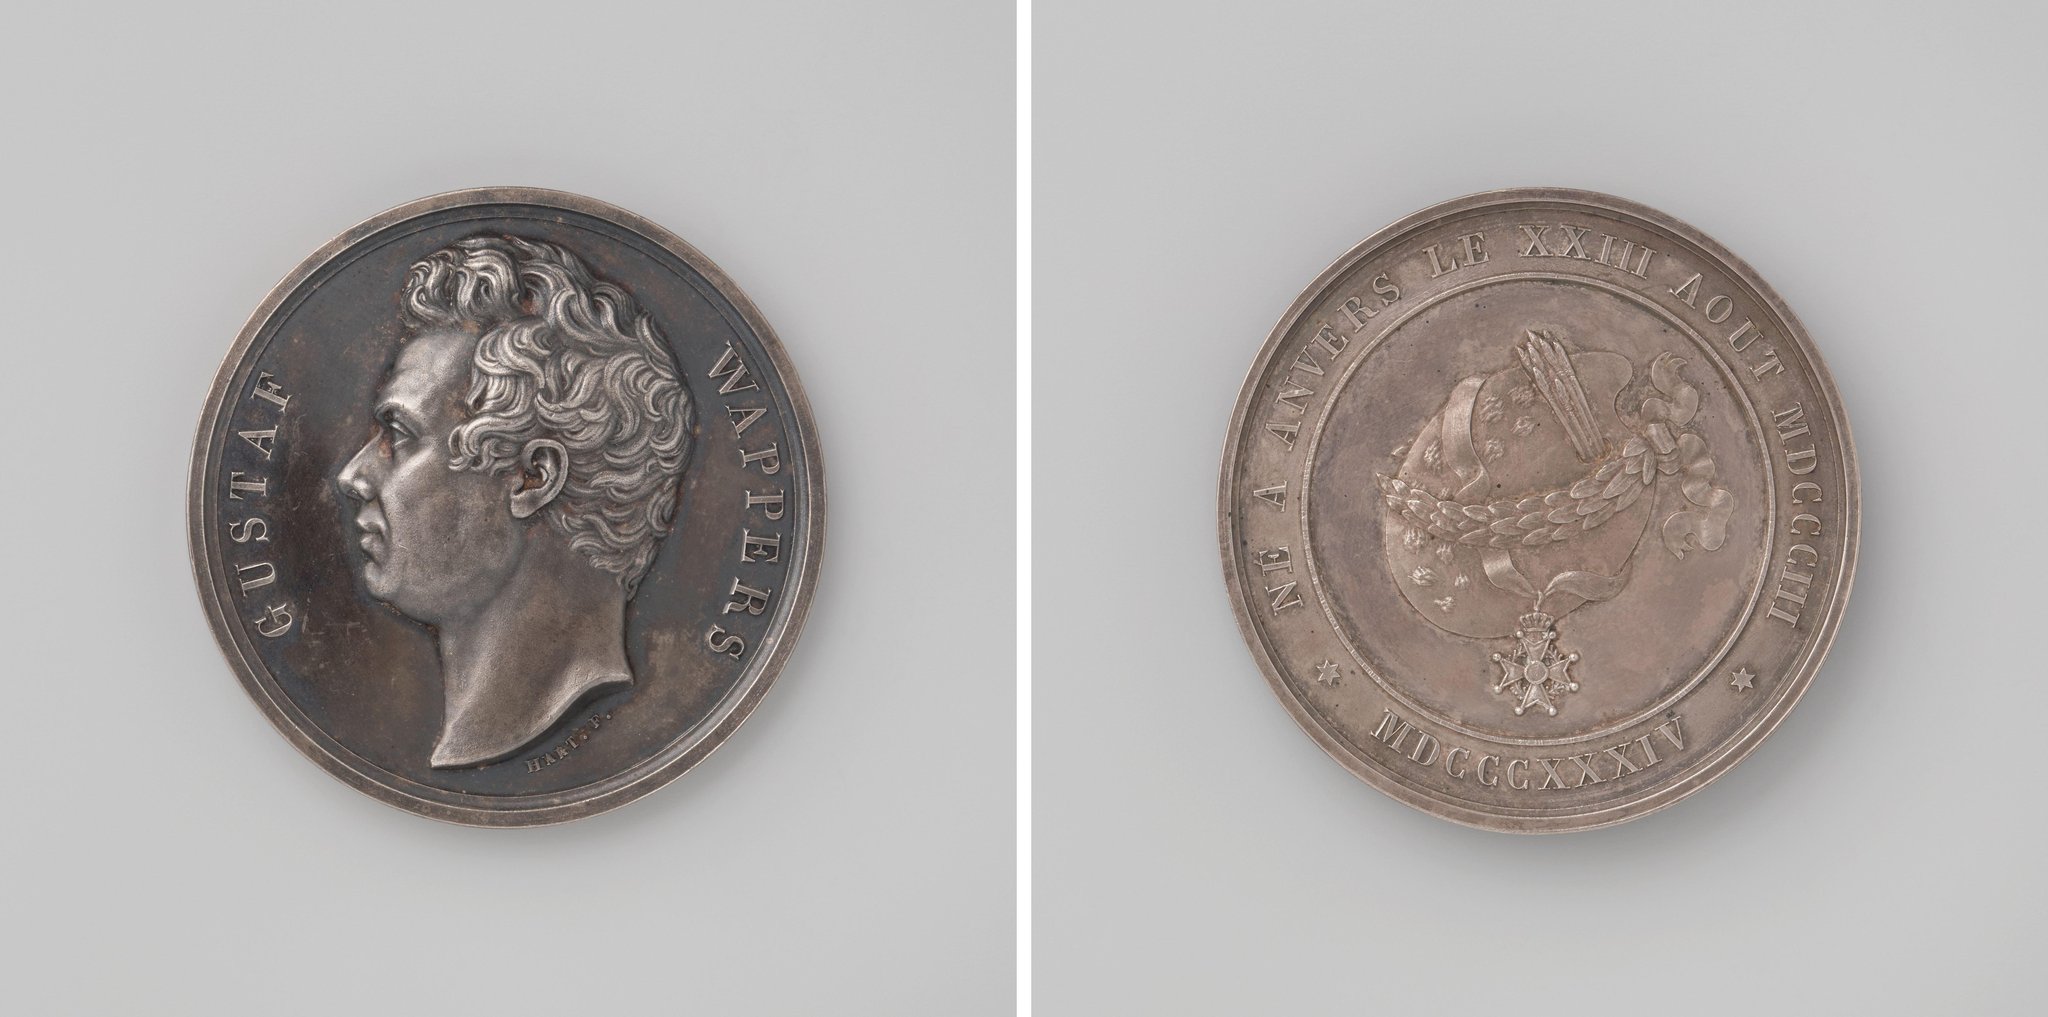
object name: history medal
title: Gustave Wappers, schilder te Antwerpen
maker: laurent joseph hart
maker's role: die cutter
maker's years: 1810-1860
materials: silver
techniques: striking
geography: brussels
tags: paris, print maker, draughtsman, gustave wappers, antwerp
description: Zilveren penning. Voorzijde: borststuk man binnen omschrift. Keerzijde: palet met penselen, omhangen metLeopold Orde en lauwerkrans binnen omschrift